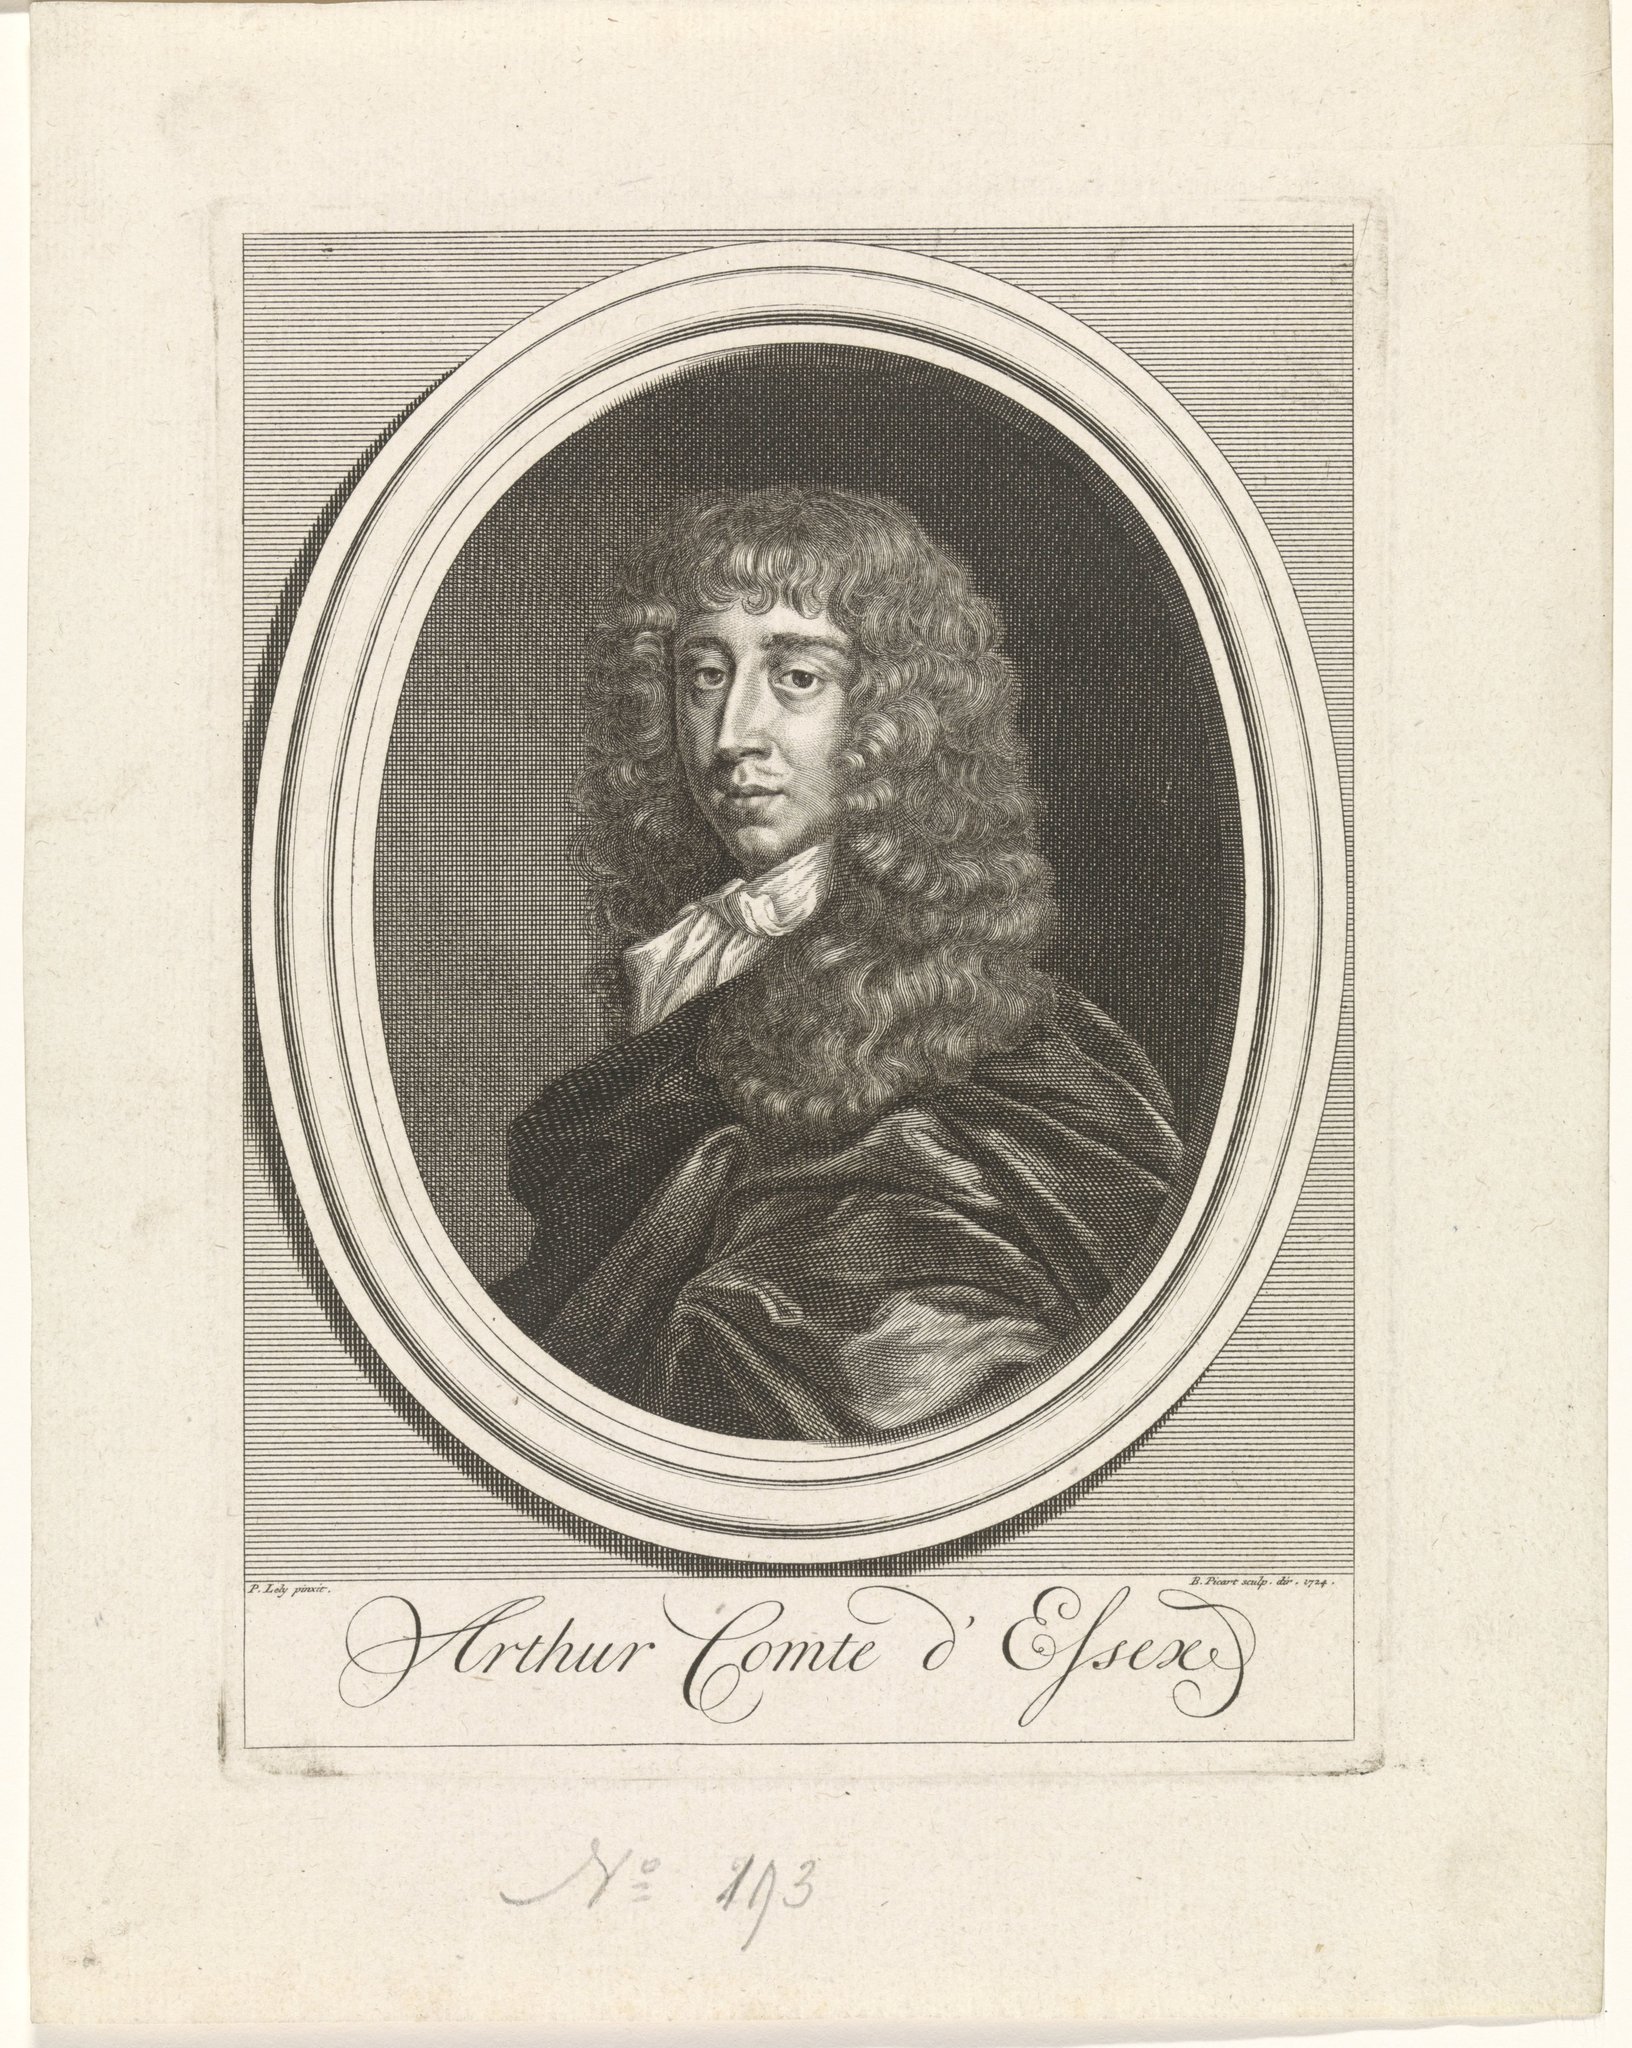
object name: print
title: Portret van Arthur Capell, eerste graaf van Essex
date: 1724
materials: paper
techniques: engraving, etching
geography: amsterdam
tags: militair, arthur capell (1e graaf van essex)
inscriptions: collector's mark: Lugt 2228, inscription: ‘N. 3 Ds.’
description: Prent als illustratie gebruikt in: Burnet, Gilbert. Histoire des dernières révolutions d'Angleterre. Den Haag: Jean Neaulme, 1725.